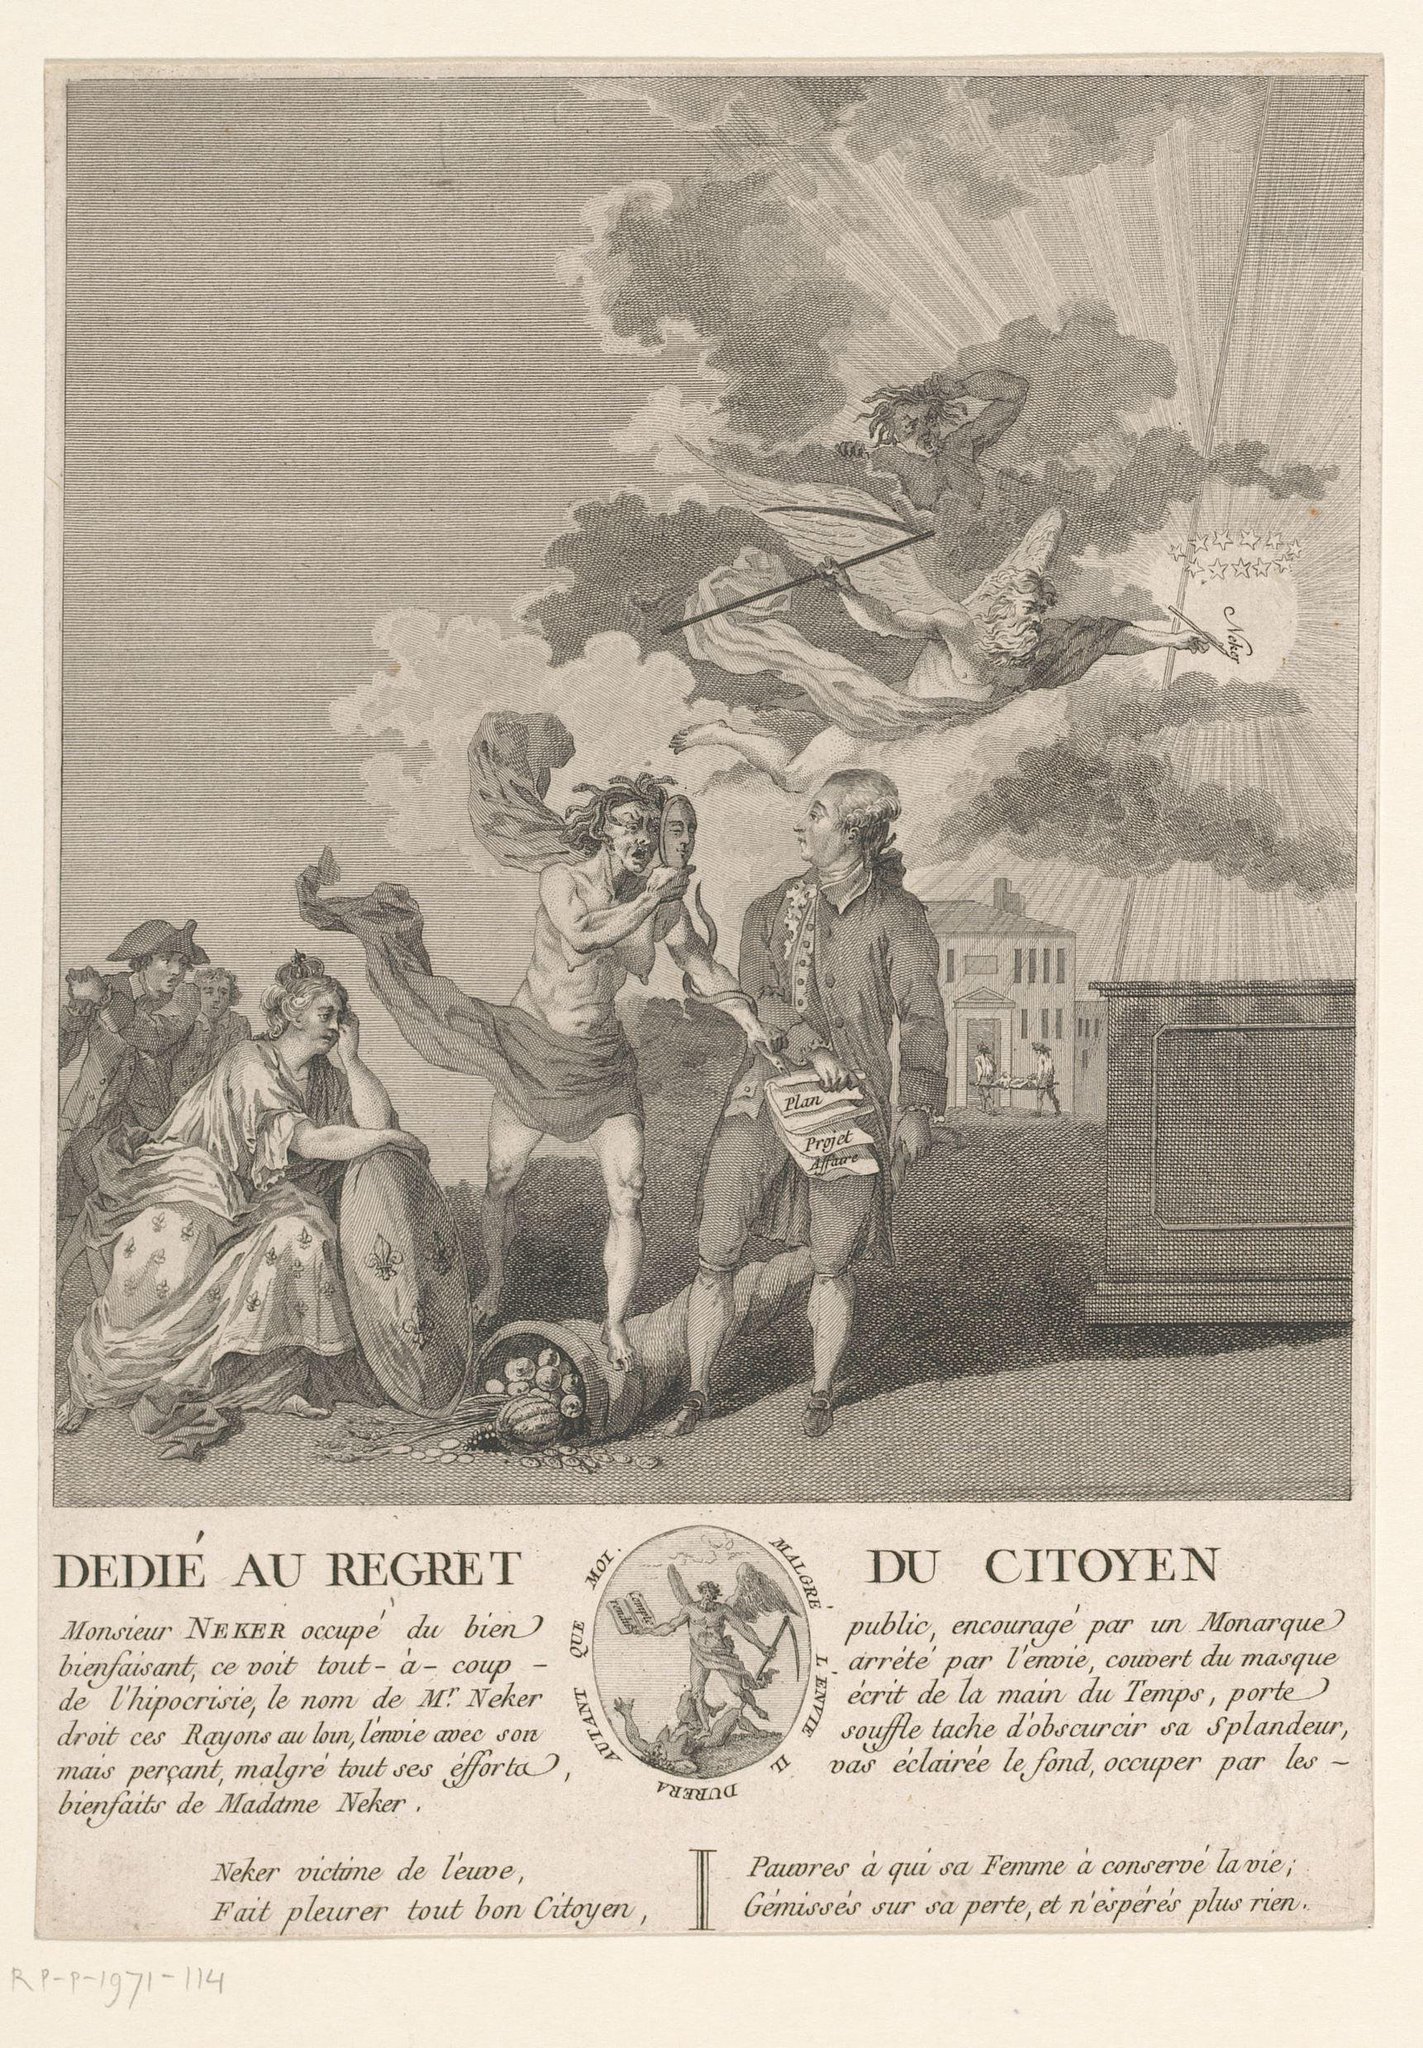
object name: print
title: Allegorie op Jacques Necker, ca. 1781-1788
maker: Anonymous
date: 1781-1788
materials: paper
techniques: etching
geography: france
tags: personifications of countries, nations, states, districts, etc., envy; 'invidia' (ripa) ~ personification of one of the seven deadly sins, father time, man with wings and scythe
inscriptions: collector's mark: Lugt 2228, collector's mark: Lugt 2760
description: Allegorie met Jacques Necker, ca. 1781-1788. Necker onheus bejegend door de gemaskerde Afgunst. In de hemel verjaagt de Tijd de Afgunst. Met Frans onderschrift en embleem verwijzend naar Neckers 'Compte rendu du roi' van 1781.